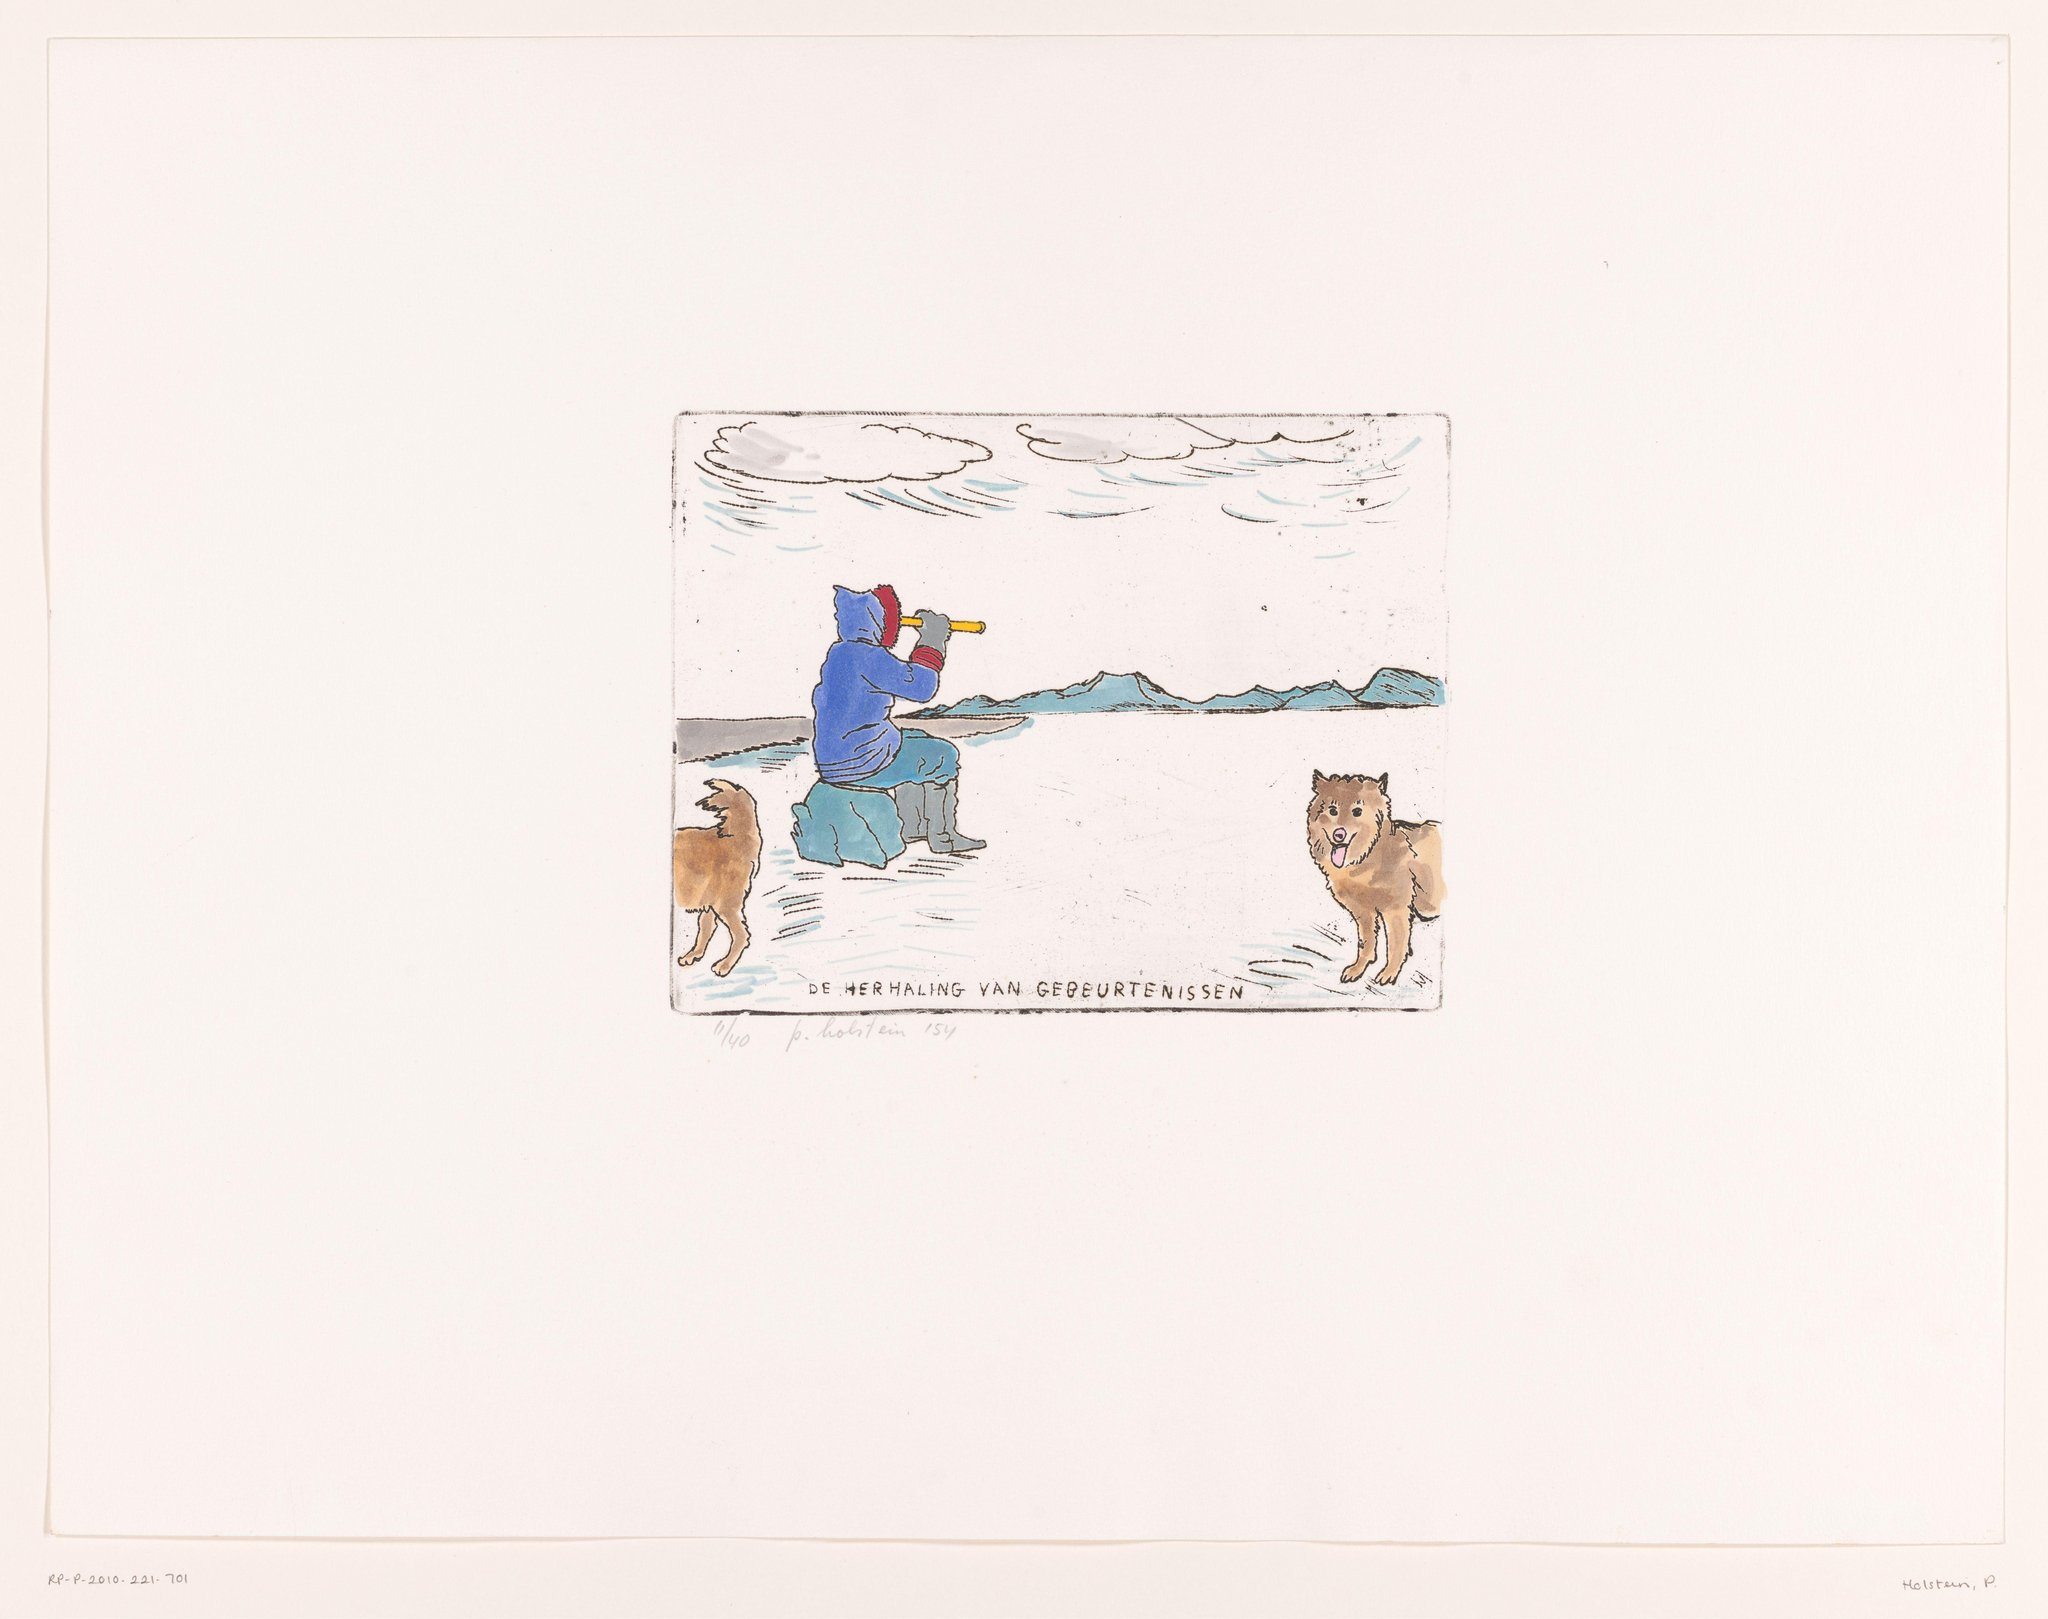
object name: print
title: De herhaling van gebeurtenissen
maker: pieter holstein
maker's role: draughtsman, painter, print maker, sculptor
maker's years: 1934-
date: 1954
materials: paper, watercolor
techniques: brush, etching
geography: amsterdam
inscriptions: edition: ‘11/40’, title: ‘DE HERHALING VAN GEBEURTENISSEN’, signature and date: ‘p. holstein '54’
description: Figuur in ijslandschap met verrekijker, uiterst links en rechts een wolf (half weergegeven).